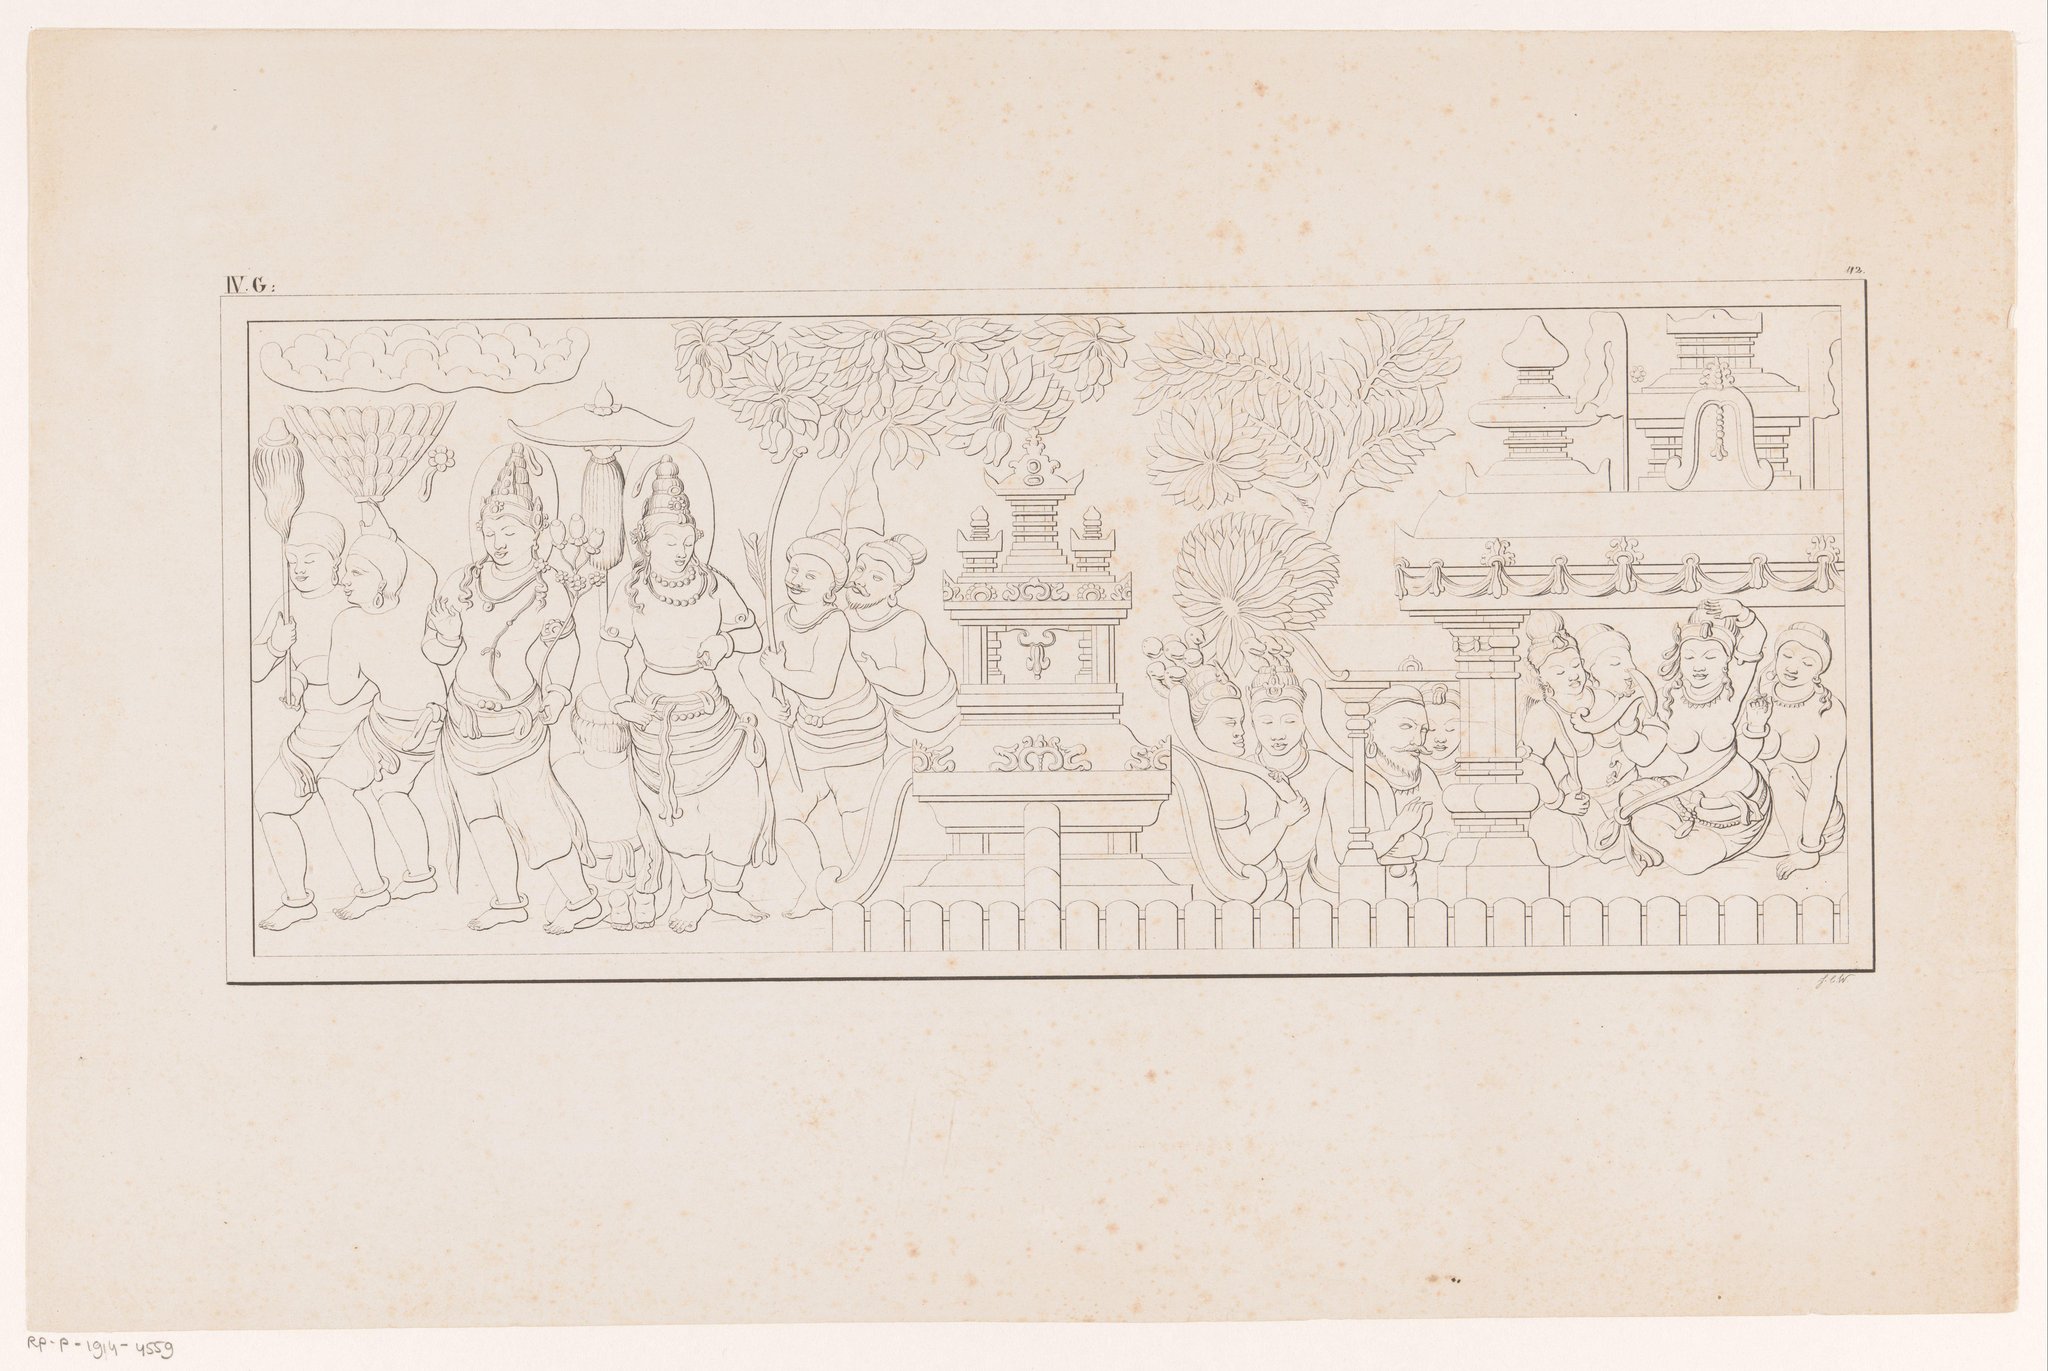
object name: print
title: Reliëf met Boeddhistische goden, mogelijk van de tempel Candi Mendut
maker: andries wiemans cz.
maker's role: print maker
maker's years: 1826-1858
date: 1836-1858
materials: paper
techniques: lithograph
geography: dutch east indies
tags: statues, paintings, etc. ~ objects of worship (hinduism, buddhism, jainism)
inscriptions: collector's mark: Lugt 2228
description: In het midden staat een altaar, links en rechts worden goden aanbeden. Genummerd links- en rechtsboven: 'IV. G' en '42'.